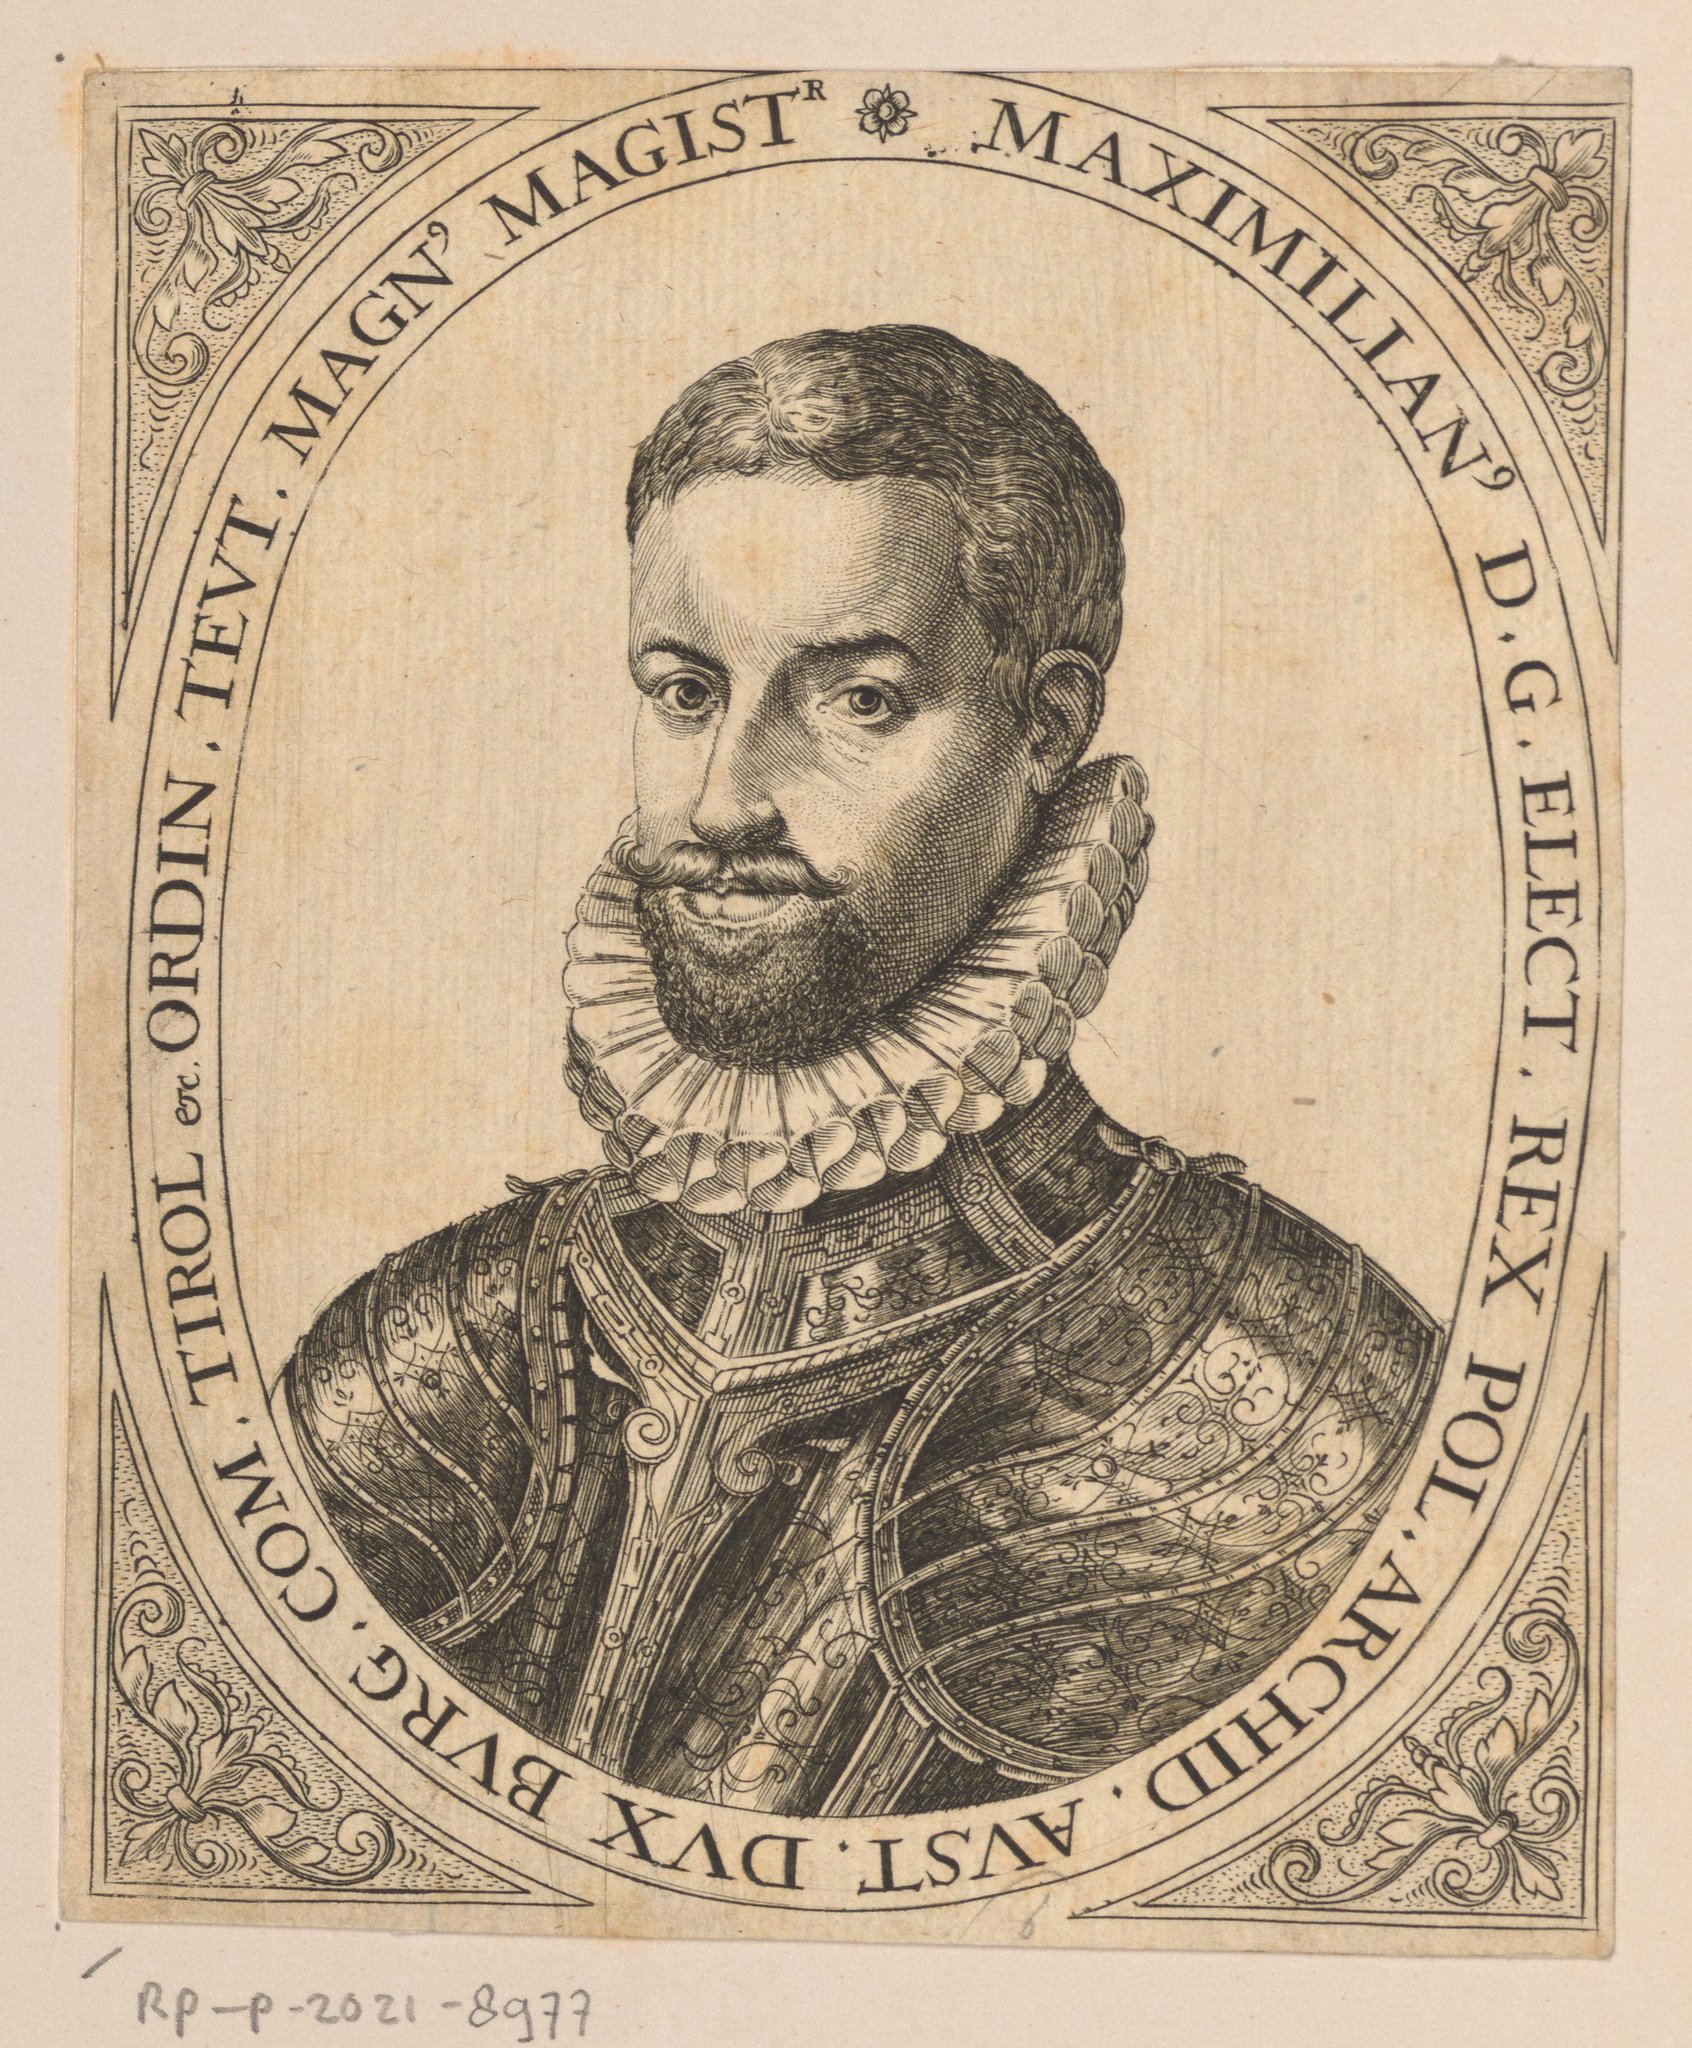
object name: book illustration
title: Portret van Maximiliaan III van Oostenrijk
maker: theodor de bry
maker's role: draughtsman, print maker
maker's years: 1528-1598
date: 1596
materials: paper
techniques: engraving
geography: frankfurt am main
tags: vienna, maximiliaan iii (aartshertog van oostenrijk), ornament ~ medallion, armour, historical persons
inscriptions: inscription: ‘zw’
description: Prent waarschijnlijk uit: Lonicerus, Johann Adam. Historia Chronologica Pannoniae: Ungarische und Siebenbürgische Historia (...). Frankfurt am Main: Theodor de Bry, 1596.